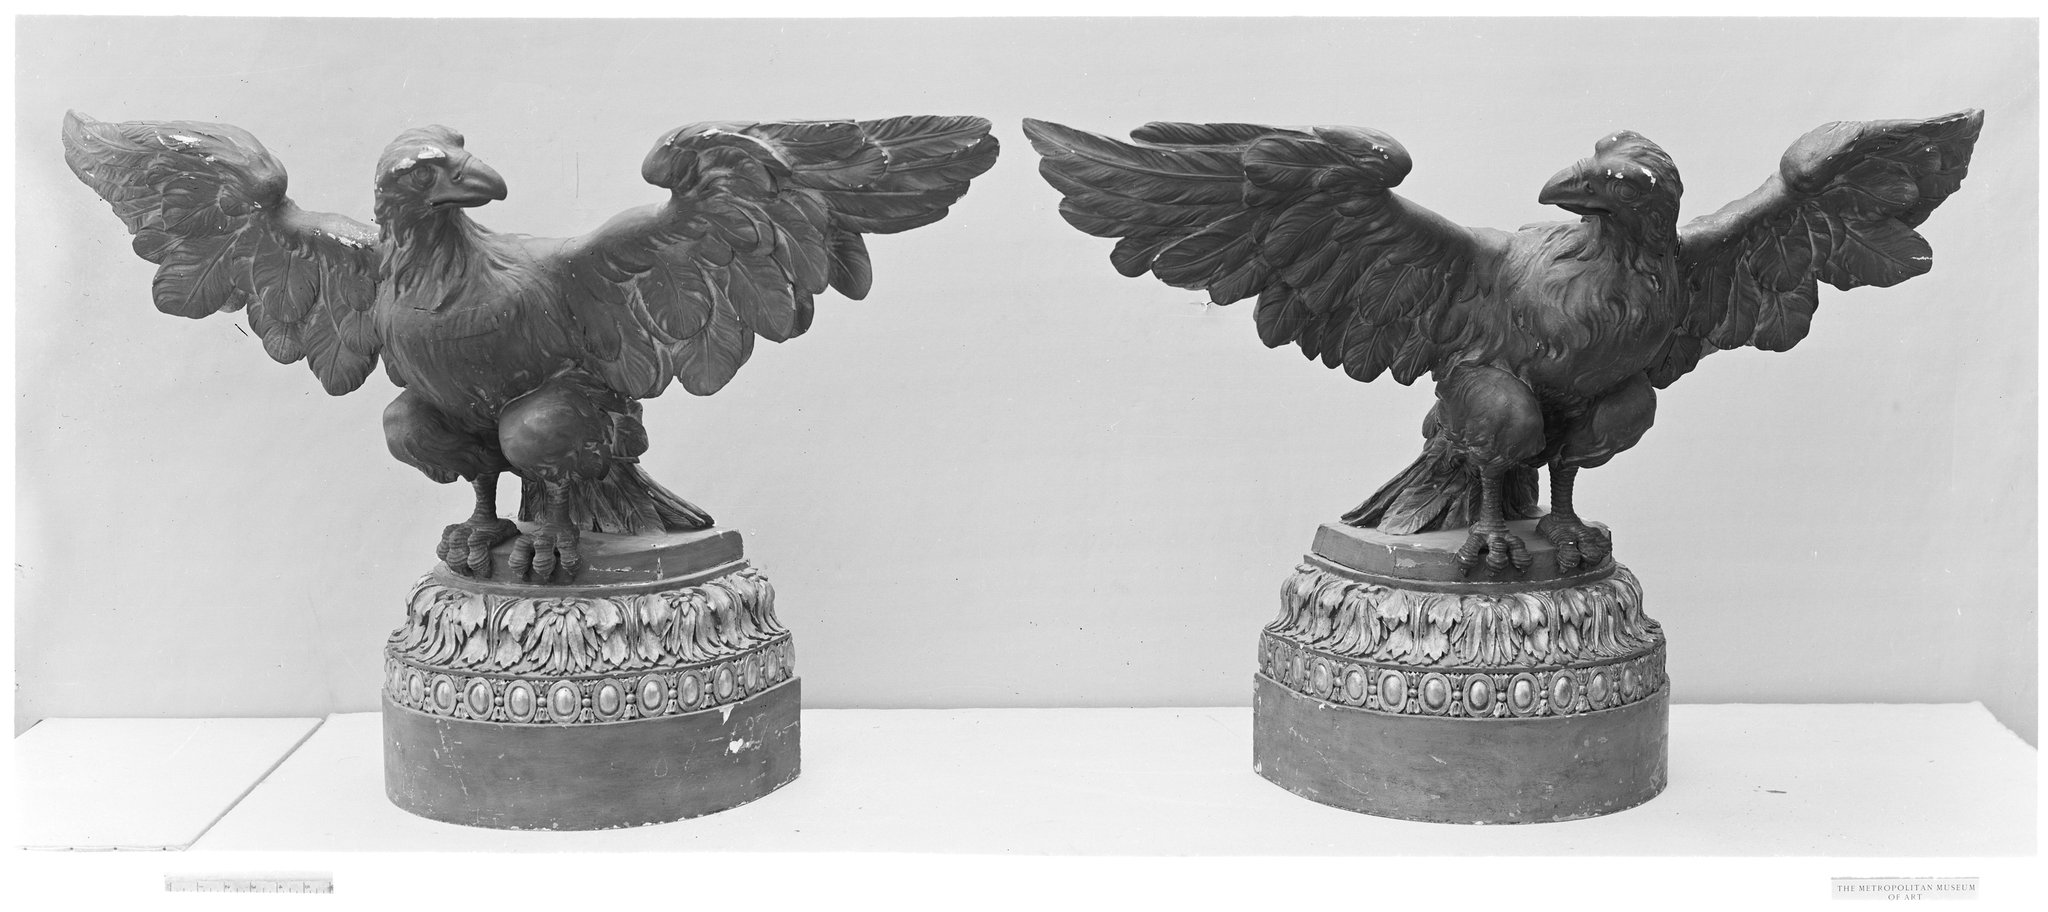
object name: figure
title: Pair of eagles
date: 1701-1800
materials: wood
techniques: carving, gilding, painting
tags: eagles